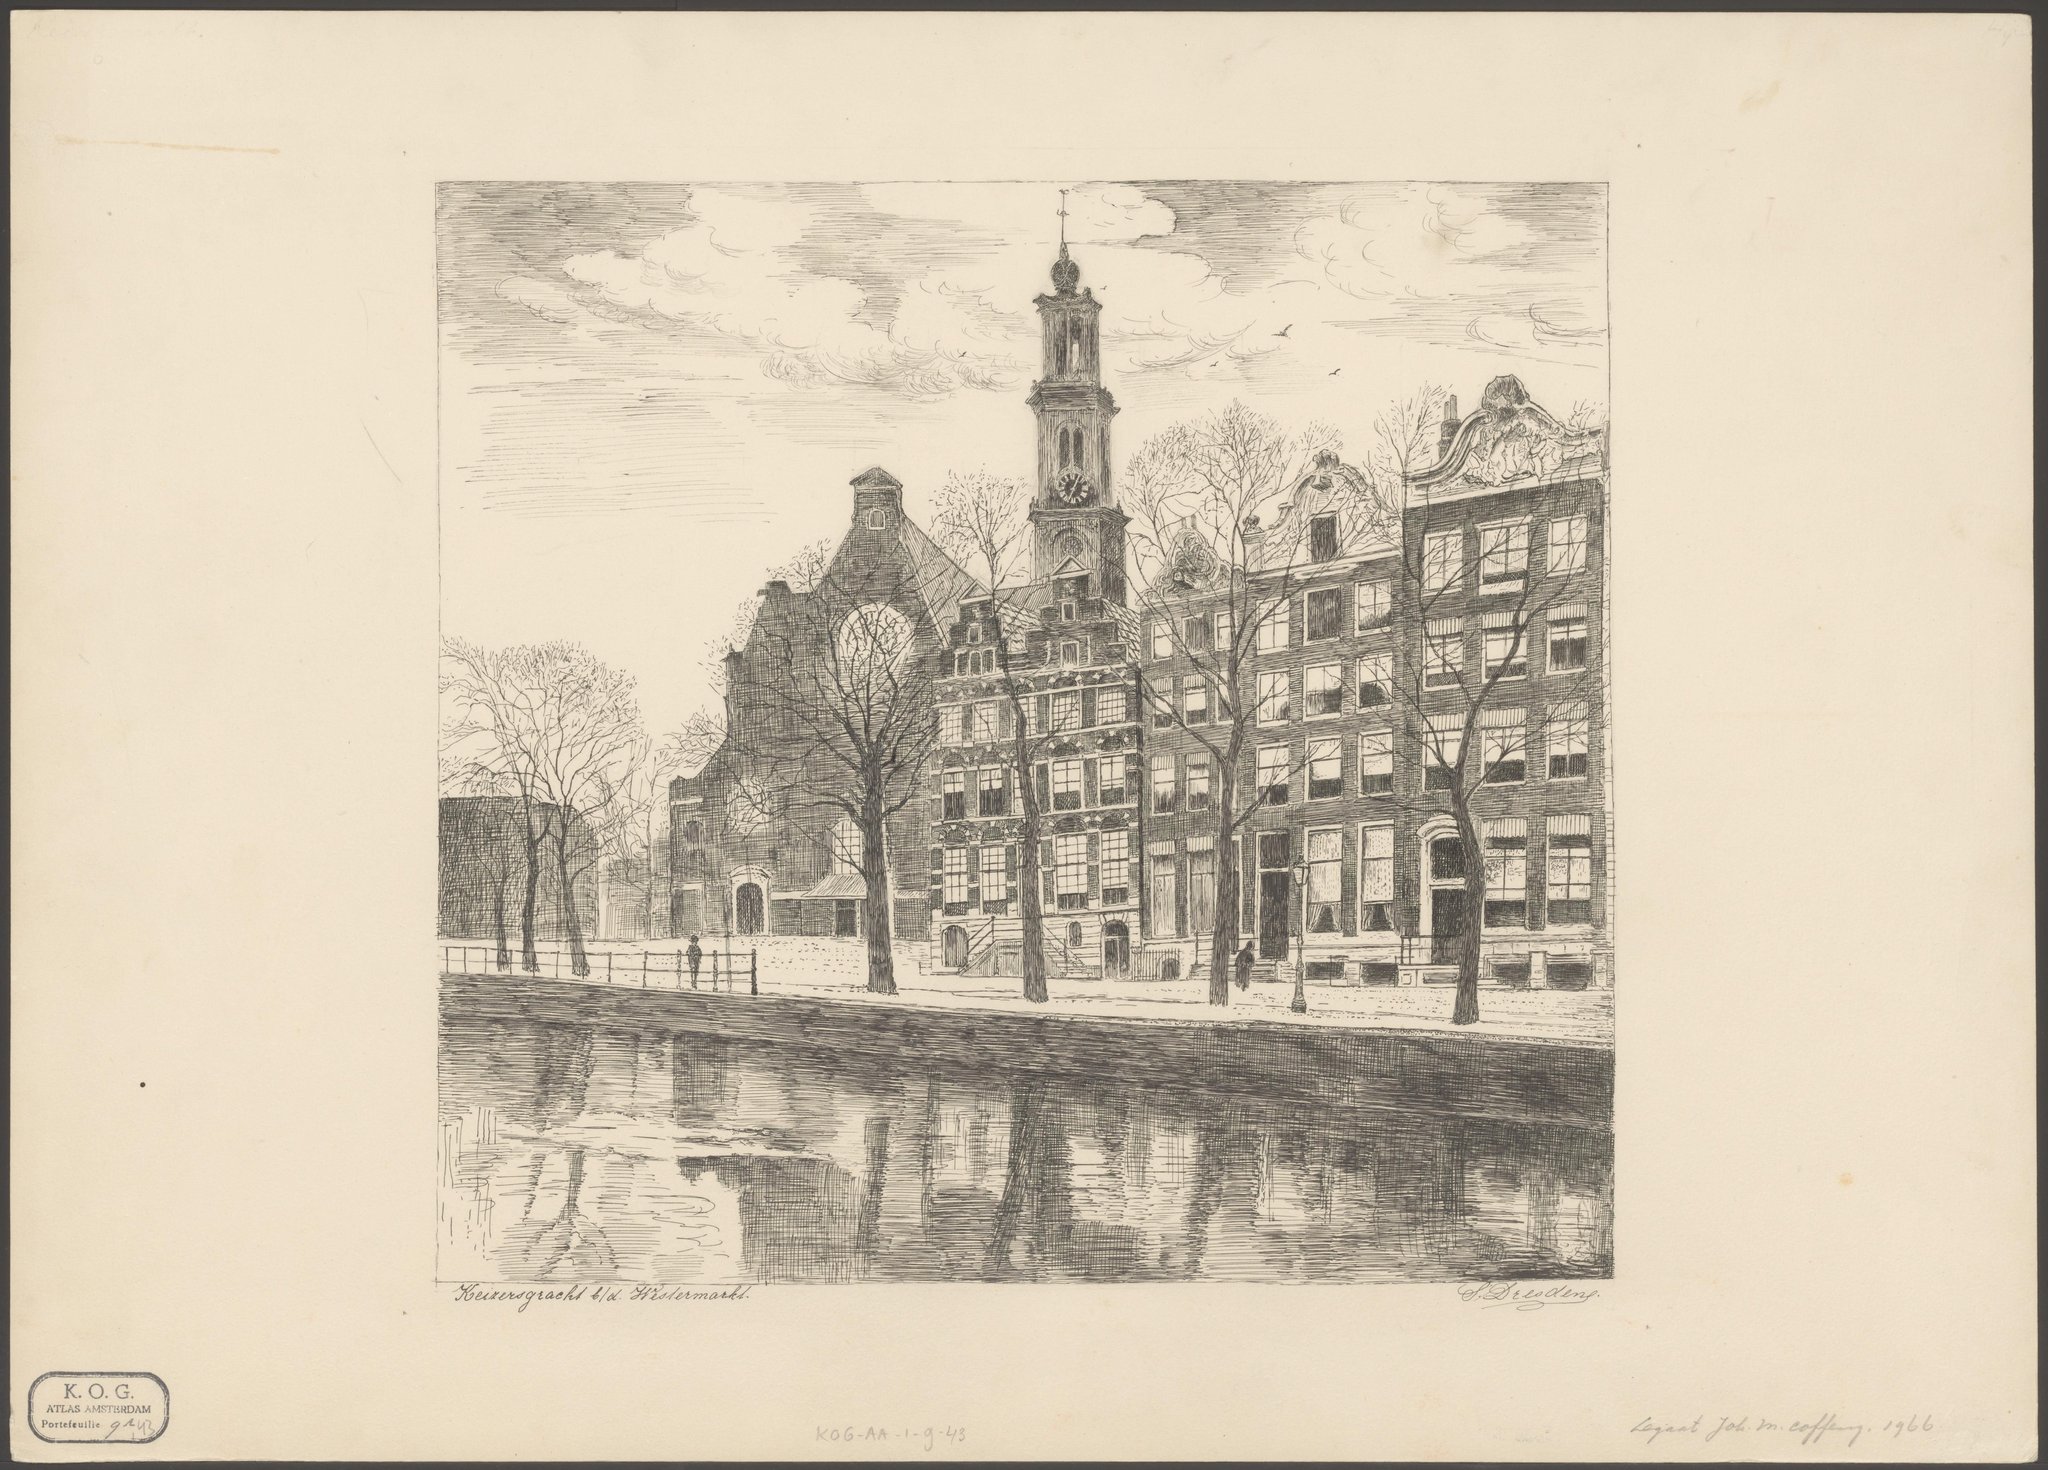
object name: drawing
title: Gezicht op de Keizersgracht bij de Westermarkt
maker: sam dresden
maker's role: draughtsman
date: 1850-1950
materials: ink, paper, pencil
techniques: pen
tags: city-view in general; 'veduta', canal, church (exterior), street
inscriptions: collector's mark: ‘9,42’ Lugt 1641b, inscription: ‘Legaat Joh. M. Coffeng. 1966.’, signature: ‘Keizersgracht b/d Westermarkt. / S. Dresden’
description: Onderwerpsrubriek binnen de Atlas Amsterdam: Kadijksplein, Karthuizerkerkhof, Kattegat, Kattenburg, Kapelsteeg O.Z., Enge Kerksteeg, Kerkstraat, Kinkerstraat, Kolk O.Z., Koningsplein, Kromboomsloot [Krom Boomssloot], Kostverlorenkade, Kwakersdwarspad, Kalverstraat, Keizersgracht (v.d. Brouwersgracht – Amstel), Klerensloot (Gedempte), Klimopstraat, Kloveniersburgwal, Kraansluis.